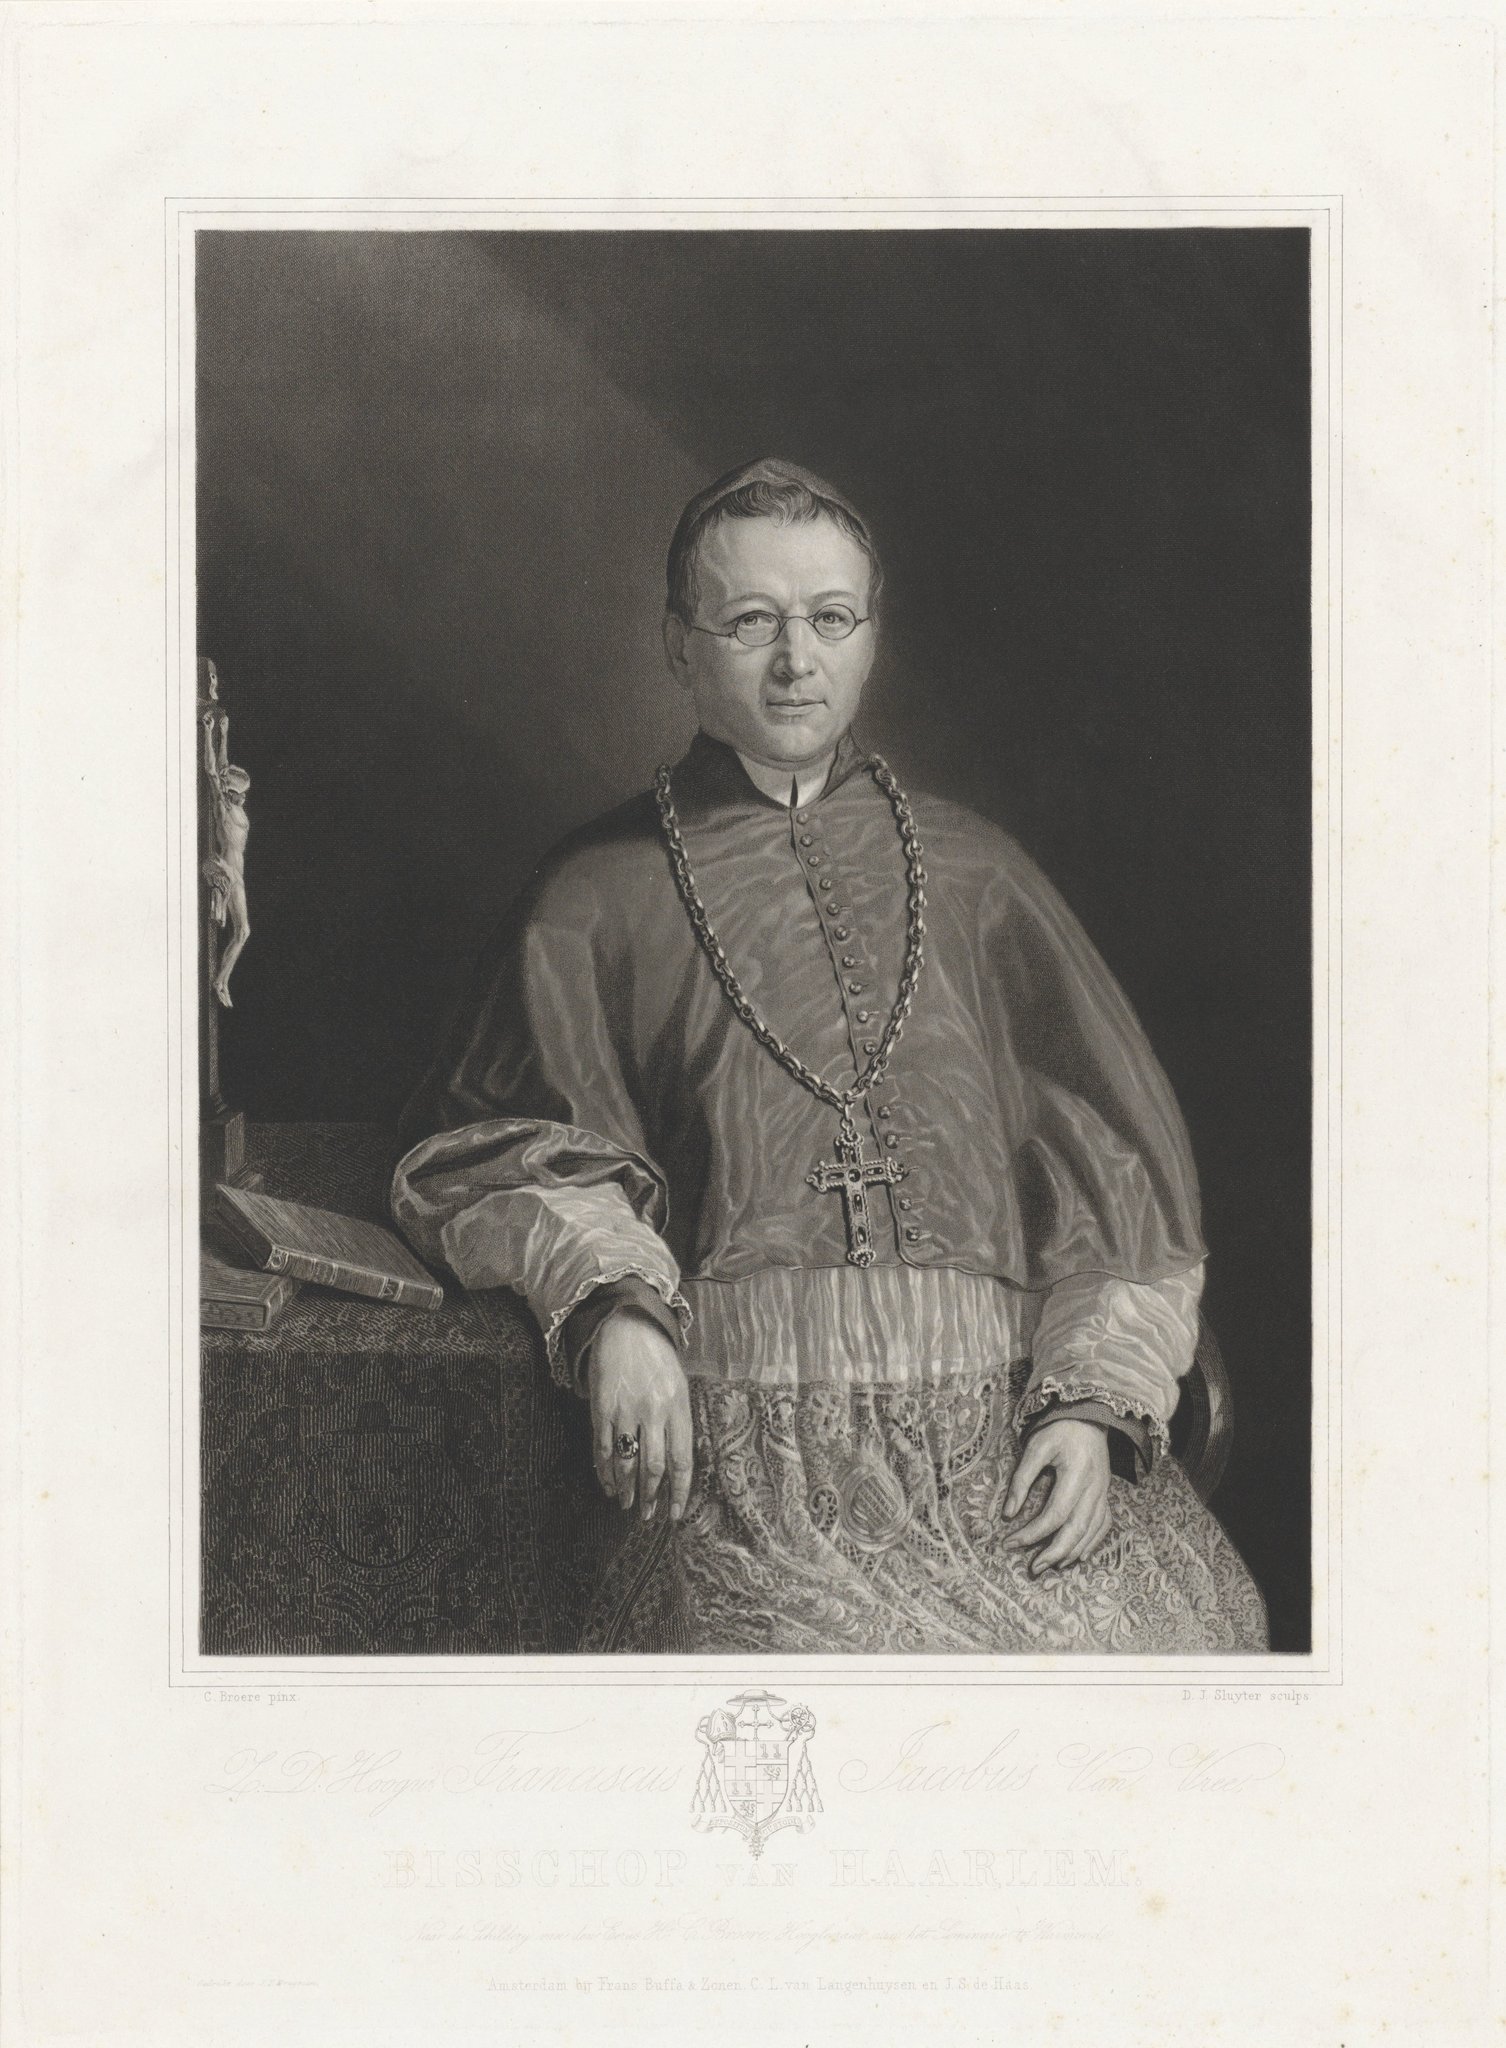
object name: print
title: Portret van Franciscus Jacobus van Vree, bisschop van Haarlem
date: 1853-1886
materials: paper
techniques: aquatint, engraving, etching, roulette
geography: amsterdam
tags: haarlem, altarcross, crucifix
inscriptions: collector's mark: Lugt 964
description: Portret van Franciscus Jacobus van Vree, bisschop van Haarlem, zittend op een stoel, zijn arm steunend op een tafel met boeken en een crucifix. Onder het portret zijn naam, functie en zijn wapen met zinspreuk.